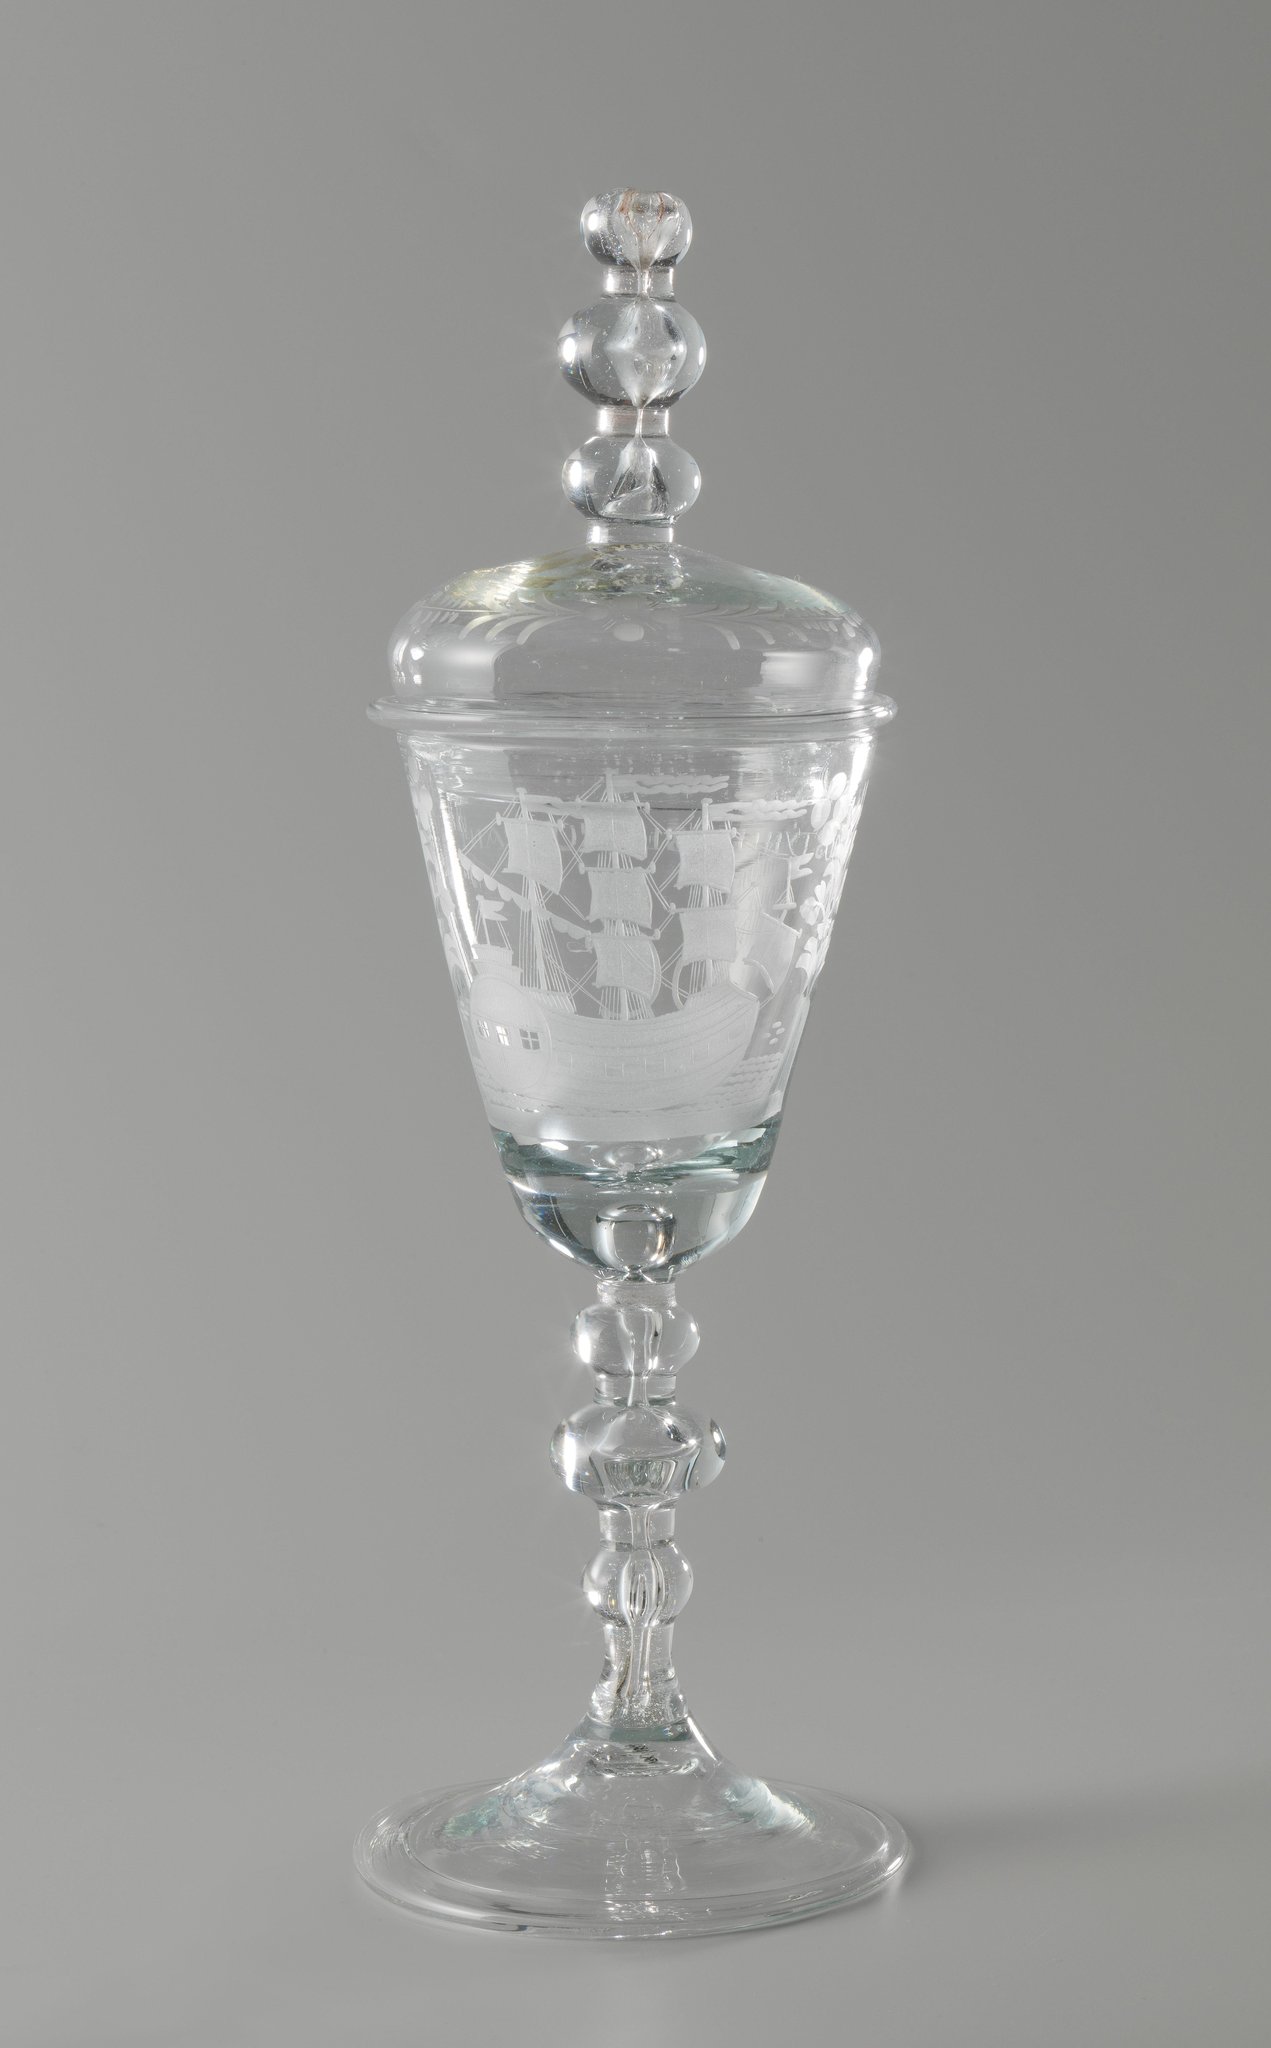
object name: goblet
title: Bokaal met deksel, met een driemaster en het opschrift: HET WEL VAREN VAN DE OOSTYNDYESE KOMPANIE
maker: Anonymous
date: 1725-1750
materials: glass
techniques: glassblowing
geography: northern netherlands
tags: verenigde oostindische compagnie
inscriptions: inscription: ‘HET WEL VAREN VAN DE OOSTYNDYESE KOMPANIE’, inscription: ‘VOC’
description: Conische voet met omgeslagen rand. Balustervormige stam met drie knopen en luchtbellen. Trechtervormige kelk met afgeronde onderzijde. Op de kelk een driemaster op een gematteerde grond, geflankeerd door bladertakken. Op de keerzijde het monogram van de Verenigde Oostindische Compagnie, VOC, onder de inscriptie: HET WEL VAREN VAN DE OOSTYNDYESE KOMPANIE. Het glas in gelegateerd met deksel.